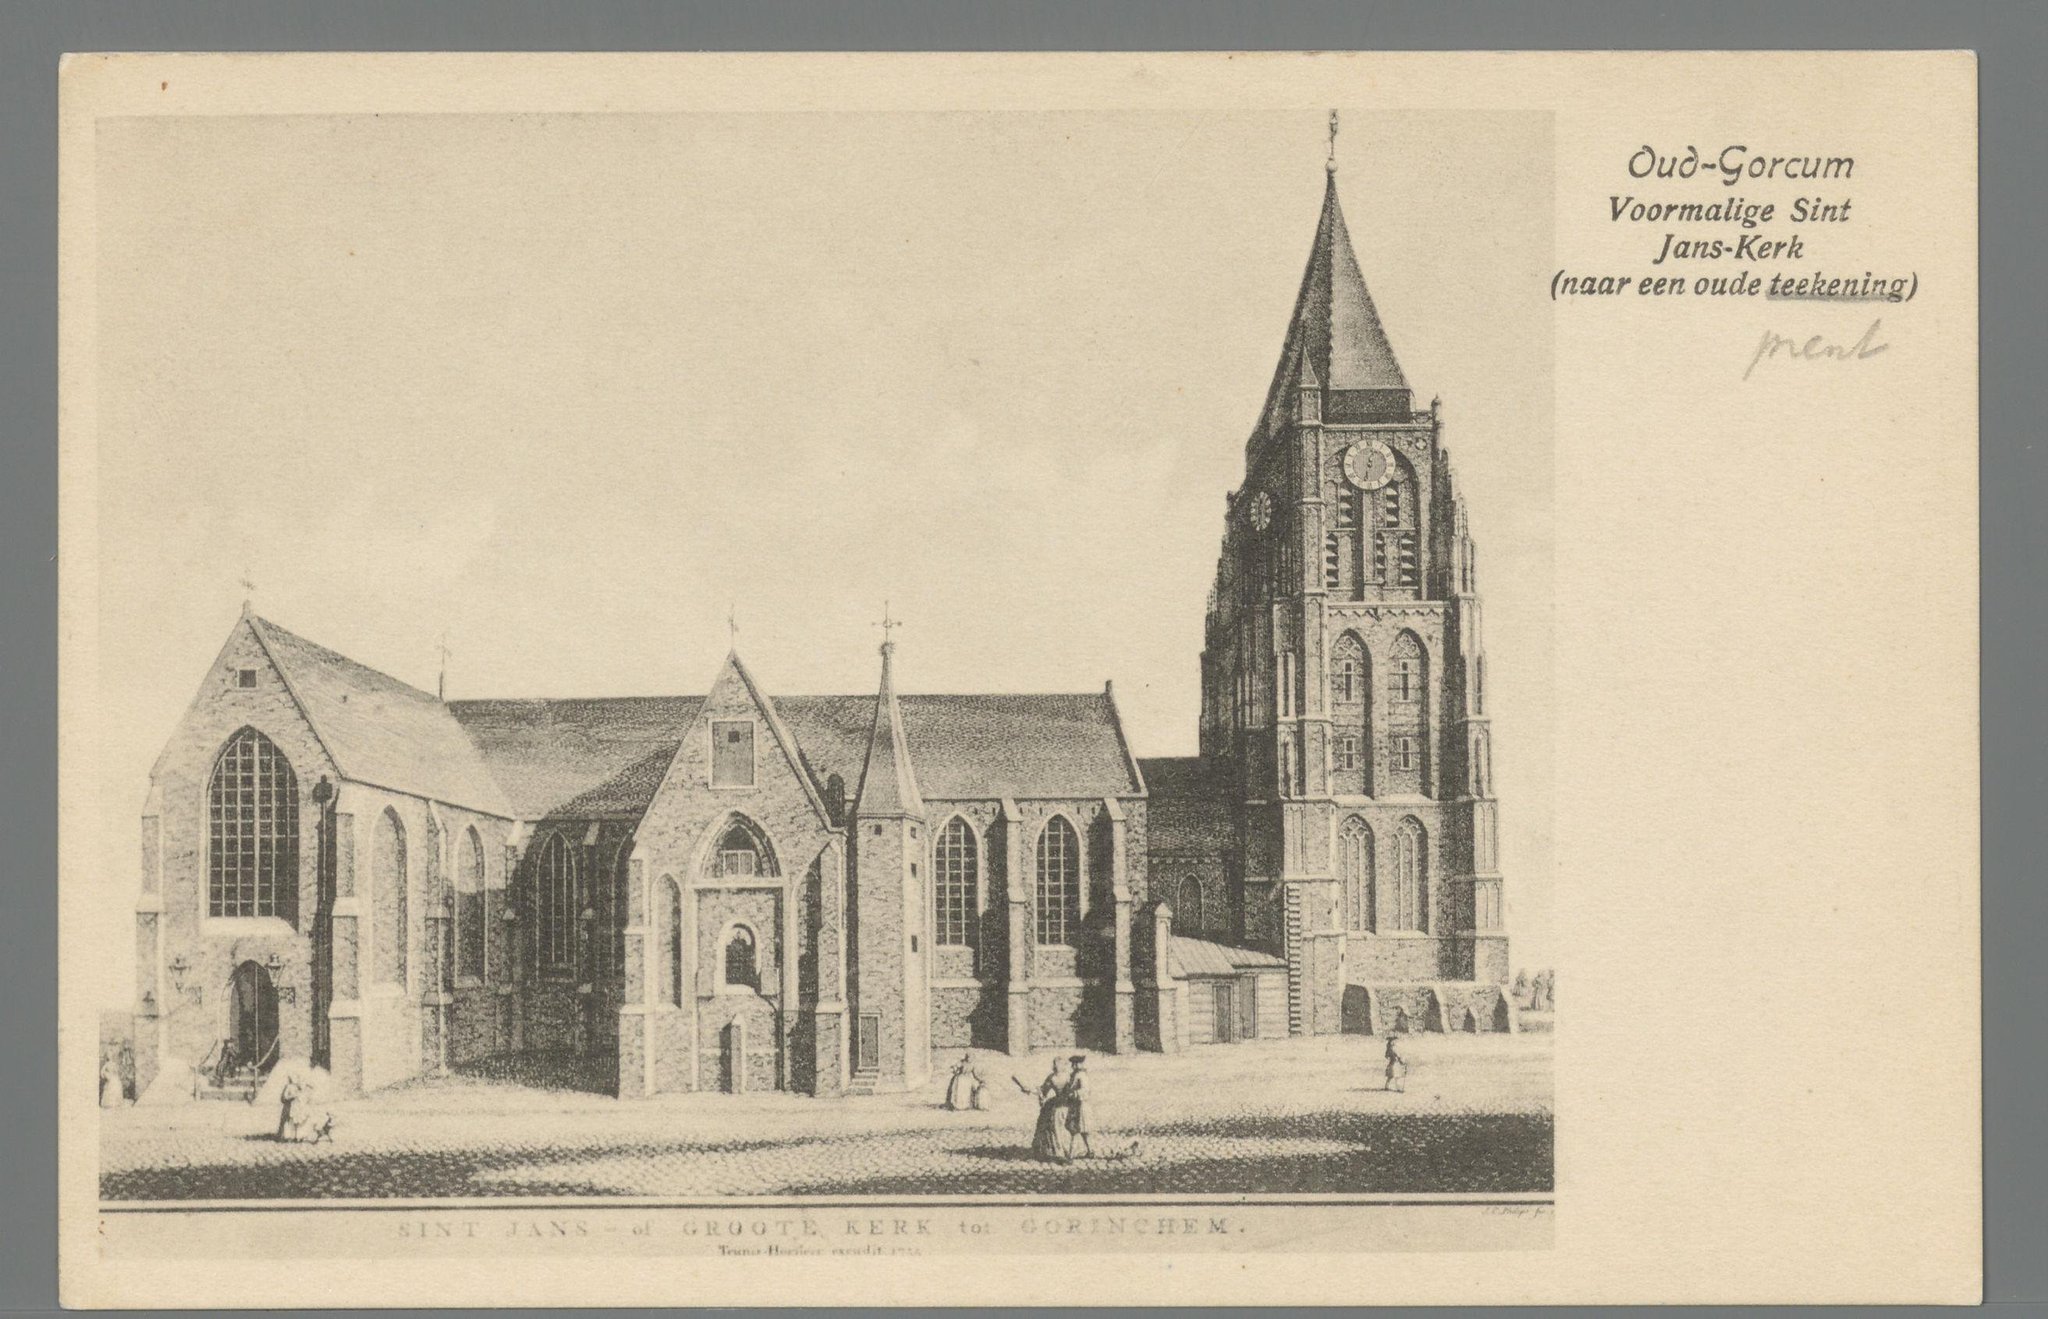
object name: photomechanical print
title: Oud-Gorcum. Voormalige Sint Jans-Kerk (naar een oude teekening)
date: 1912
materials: cardboard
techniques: photograph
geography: gorinchem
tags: church (exterior)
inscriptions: date